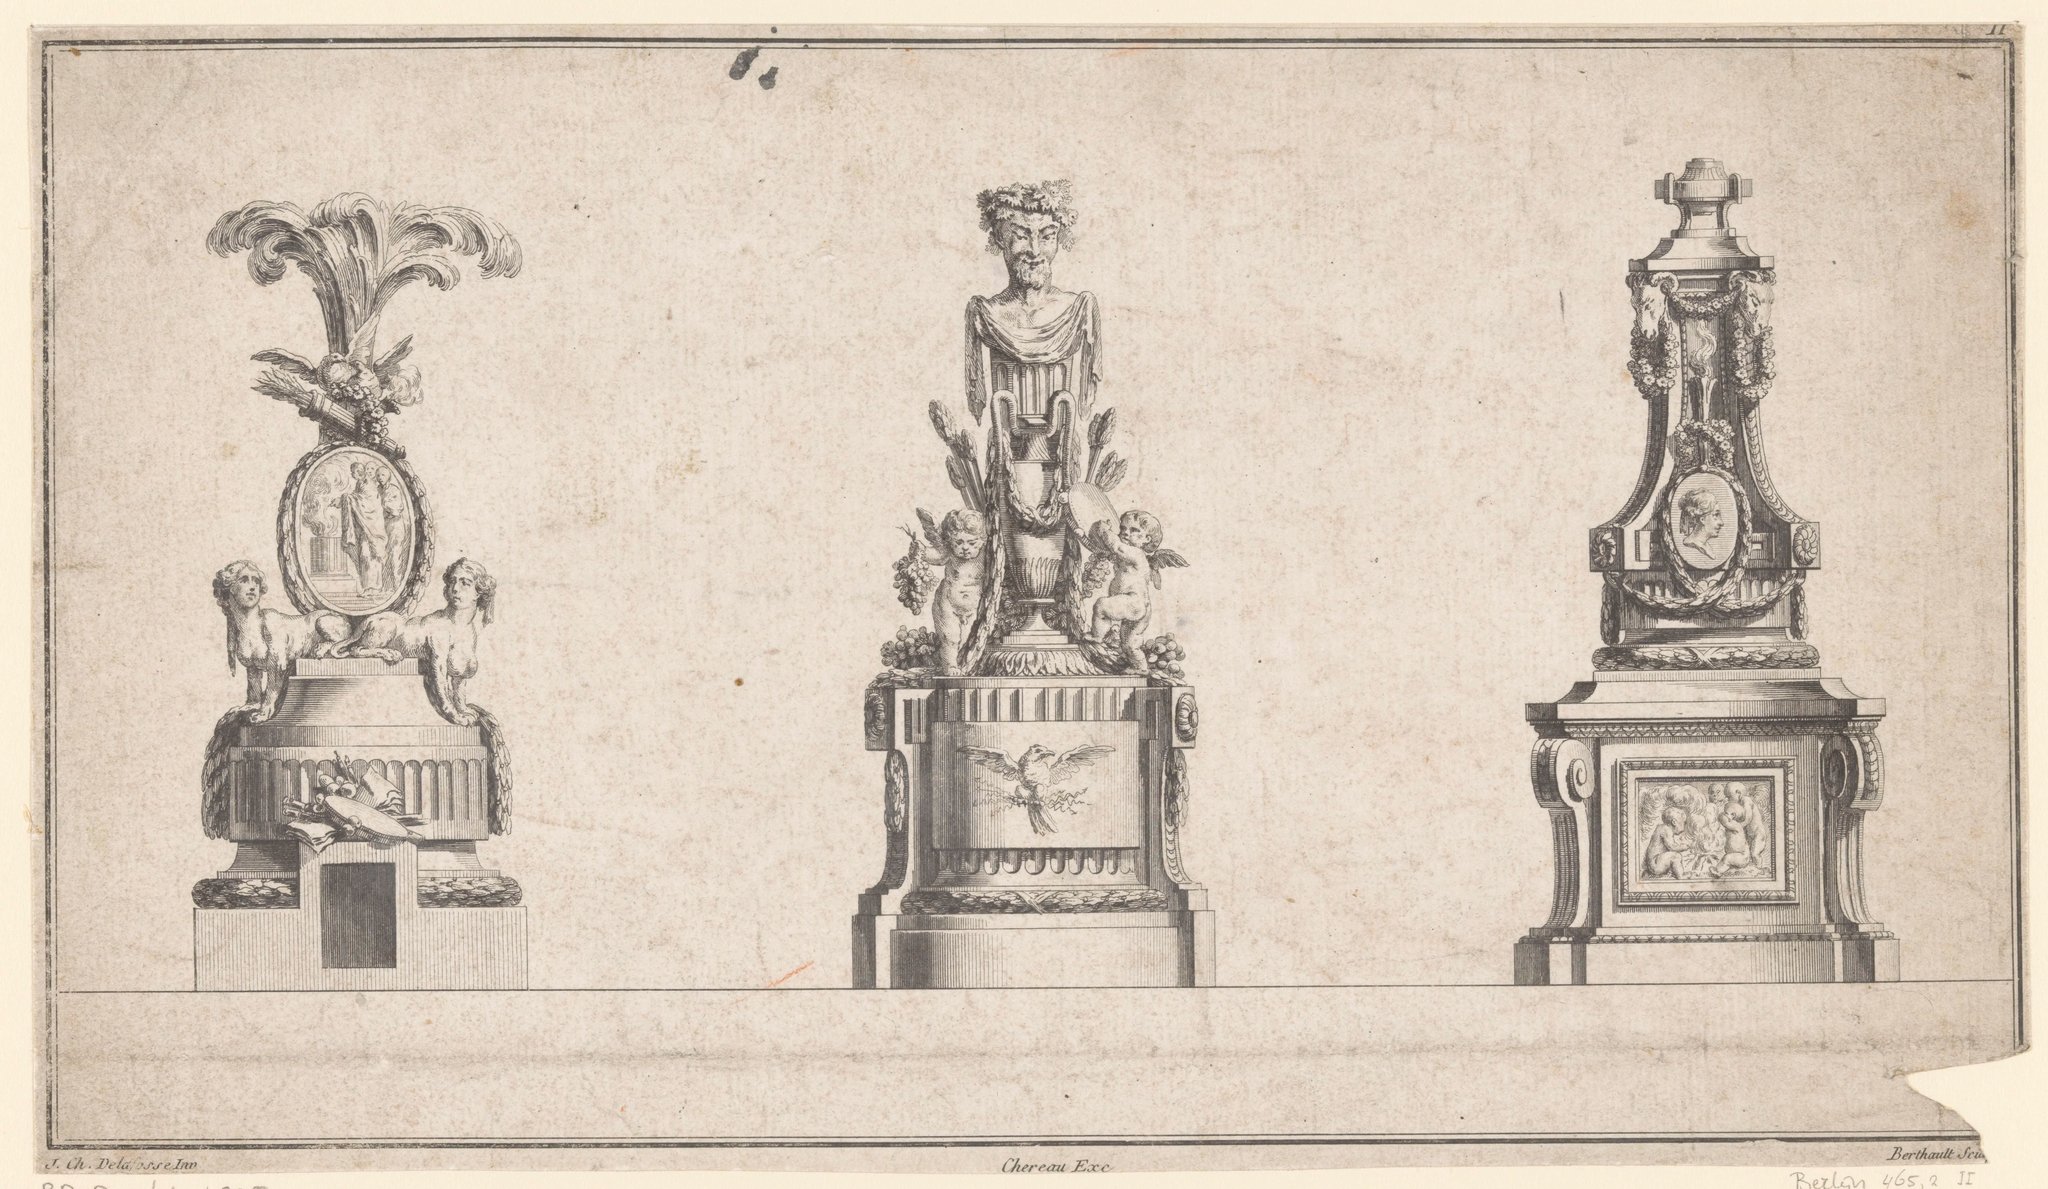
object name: print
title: 33e Cahier II Cahier de Poëles, Piedestaux, Athéniennes et Frises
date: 1771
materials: paper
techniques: engraving, etching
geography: paris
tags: monument, statue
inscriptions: collector's mark: Lugt 2760, collector's mark: Lugt 2228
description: Links een monument met twee sfinxen en een medaillon. In het midden een monument met putti, een vaas en een Bacchusbuste. Rechts een monument met medaillon en ramskoppen.